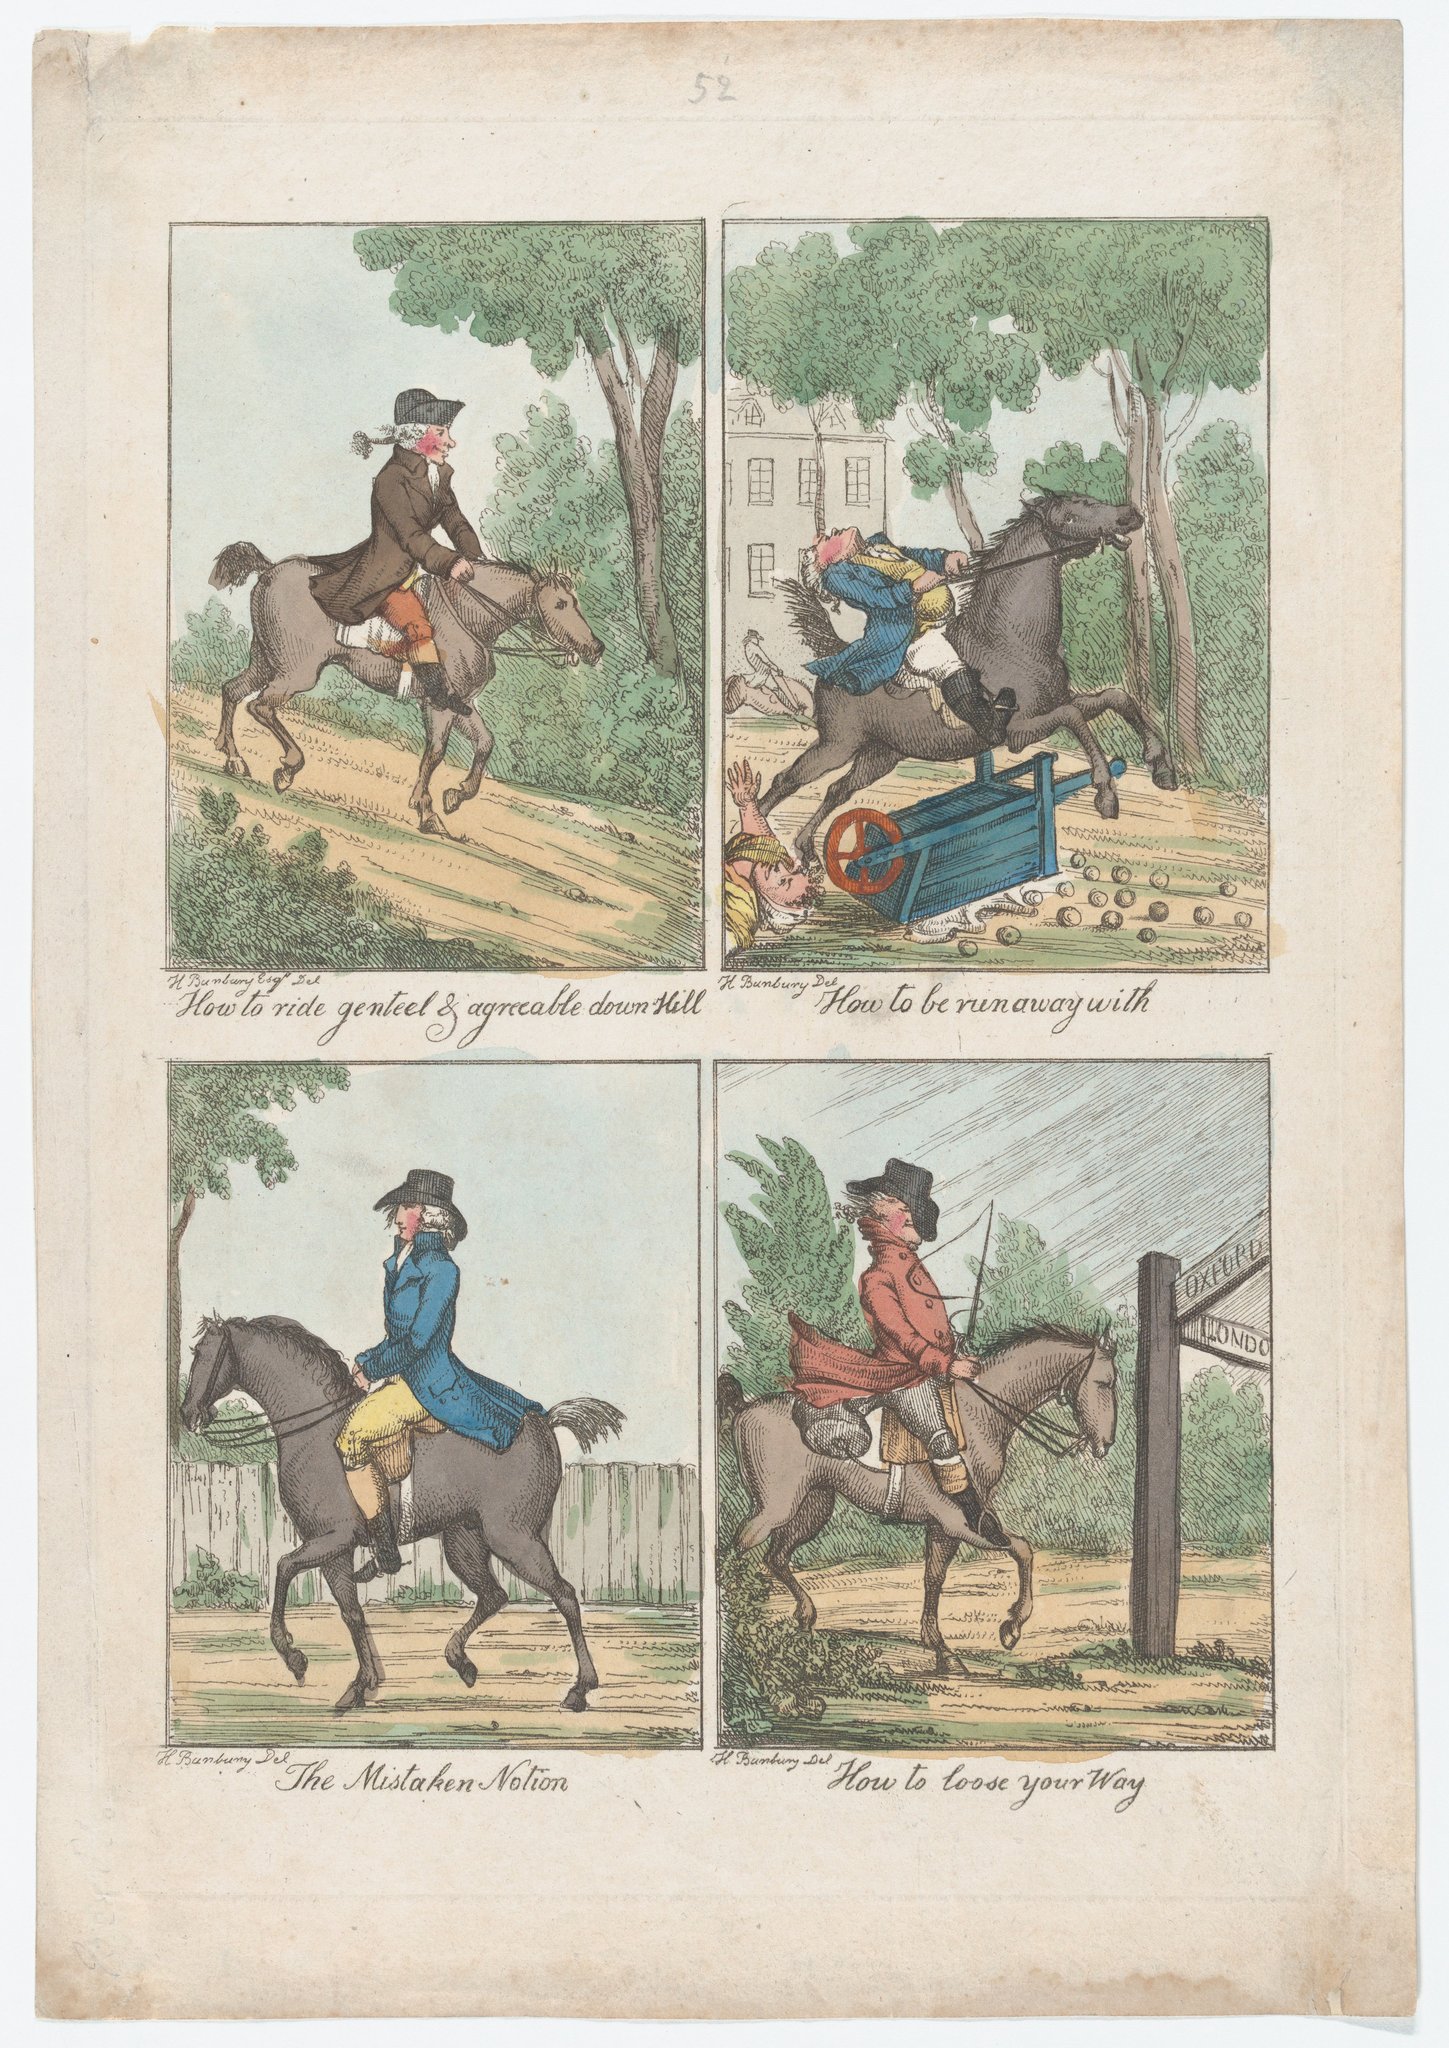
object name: print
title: Four Scenes: How to Ride Genteel & Agreeable Down Hill; How to be Run Away With; The Mistaken Notion; How to Loose Your Way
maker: henry william bunbury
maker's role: artist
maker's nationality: british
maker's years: 1750-1811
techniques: etching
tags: satire,men,horses